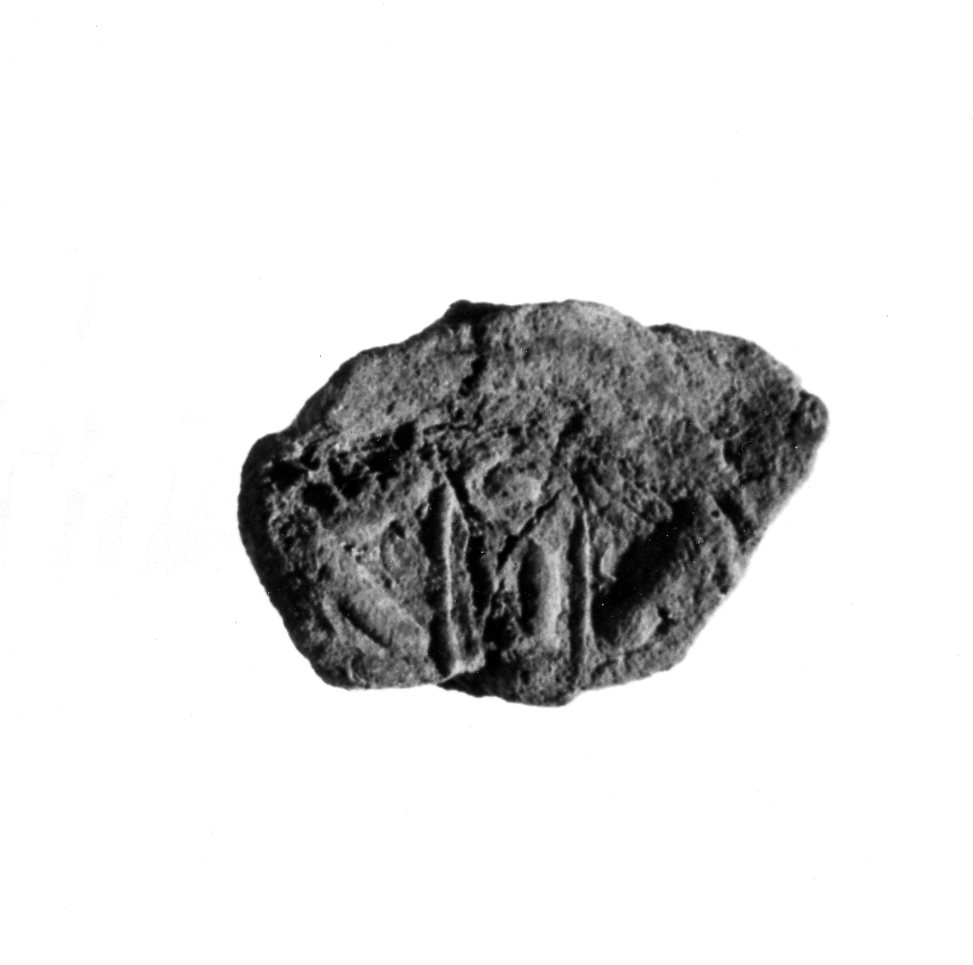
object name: sealing, nebmaatre, amenhotep iii, horus, falcon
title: Document Sealing with the Throne Name of Amenhotep III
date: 1390-1352 BCE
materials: mud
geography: egypt